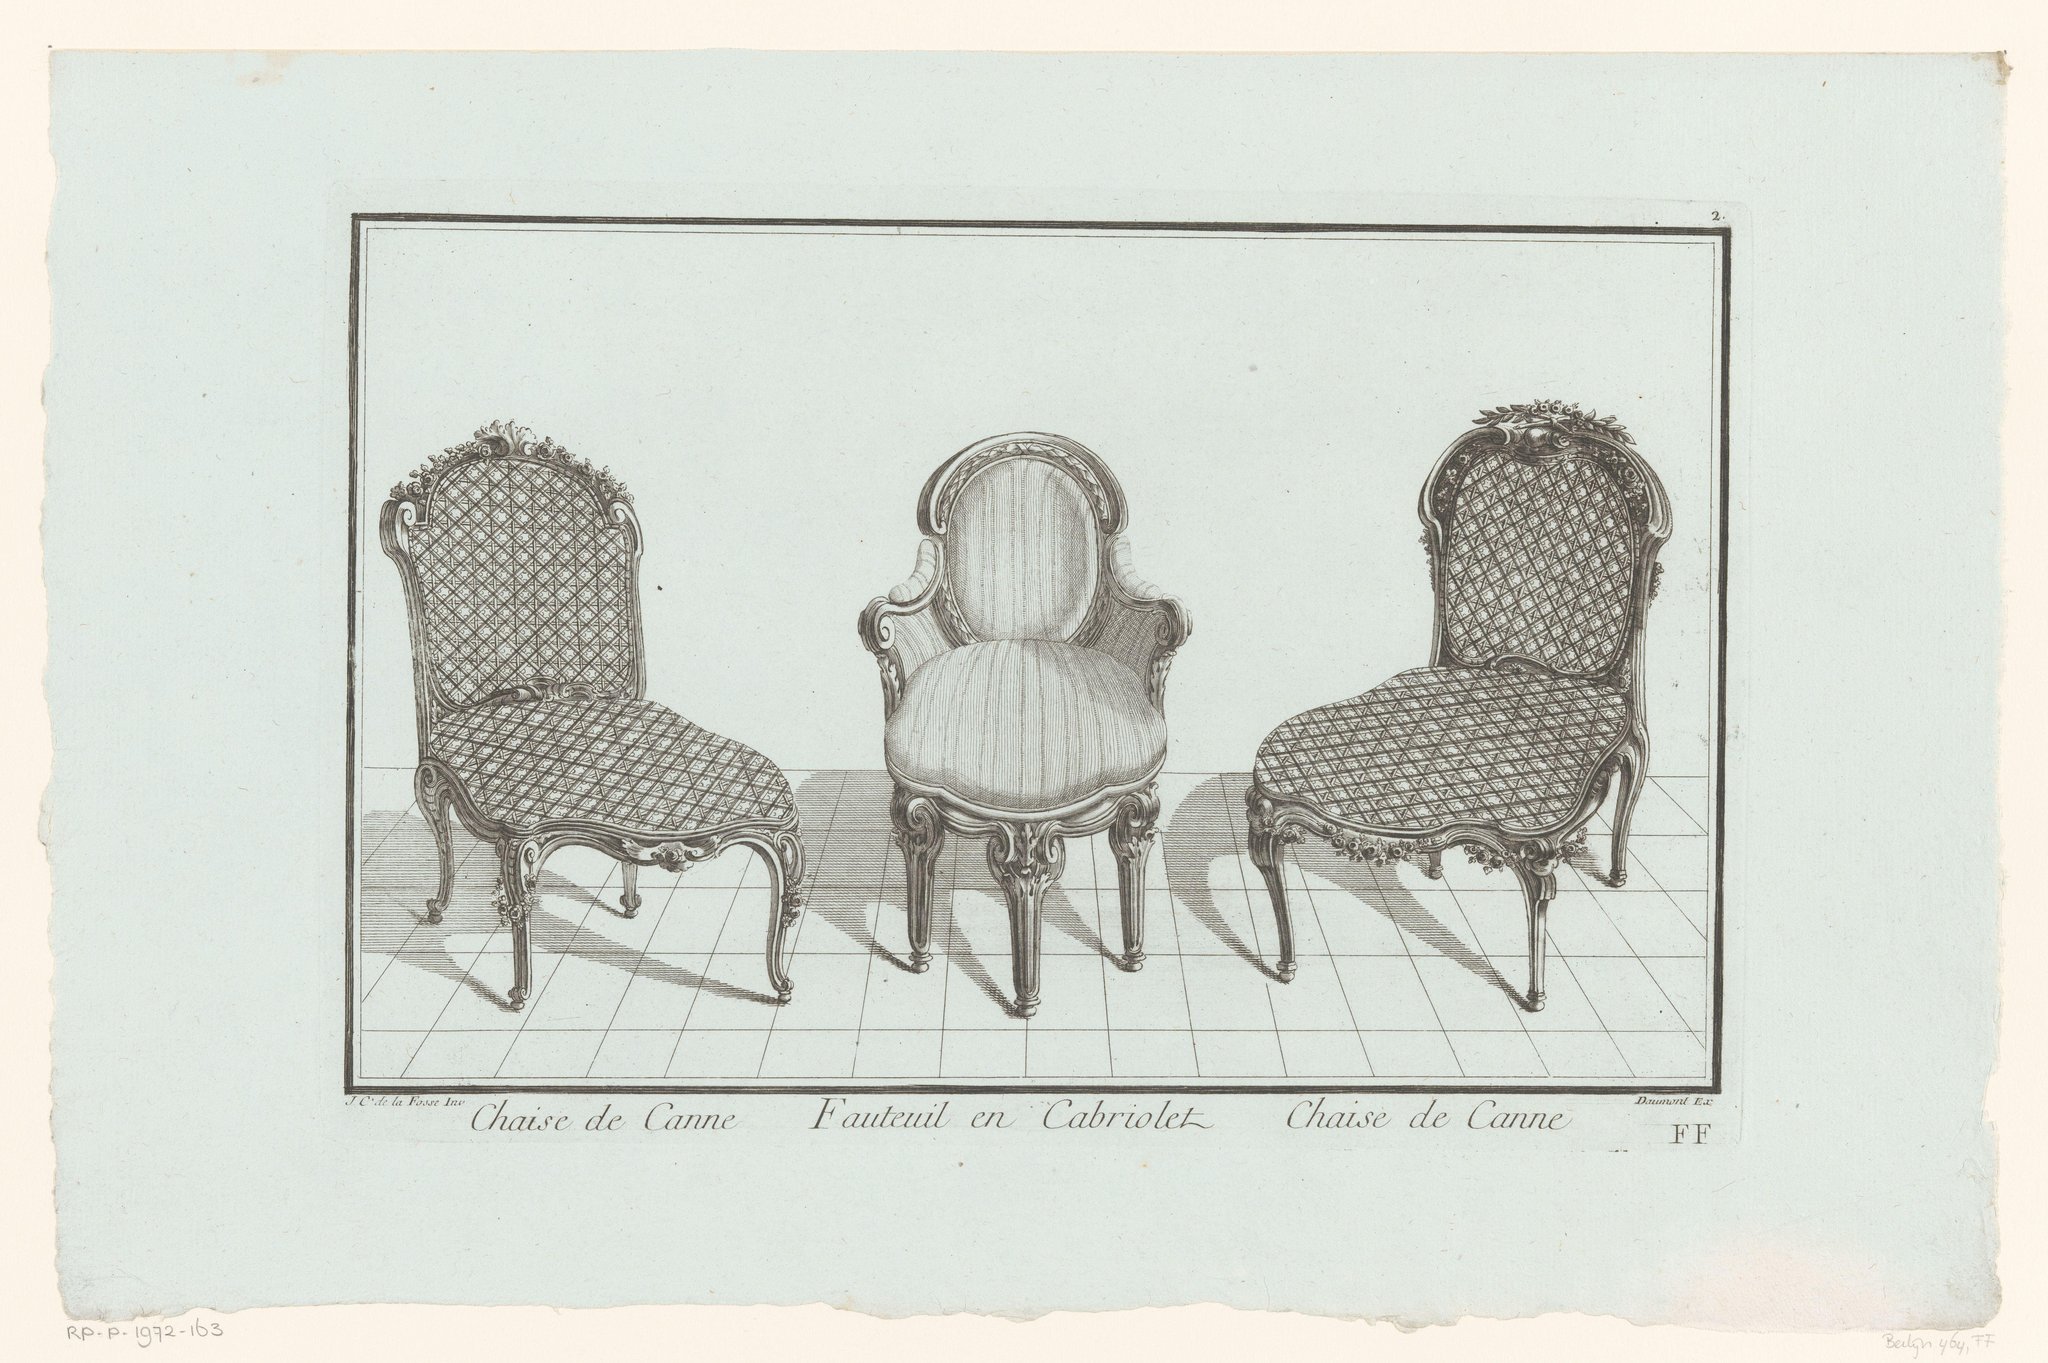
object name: ornament print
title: Chaise de Canne / Fauteuil en Cabriolet / Chaise de Canne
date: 1745-1775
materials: paper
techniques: engraving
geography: paris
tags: chair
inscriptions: collector's mark: Lugt 2228, collector's mark: Lugt 2760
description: Twee stoelen met een geruite bekleding en een stoel met armleuningen en een gestreepte bekleding.